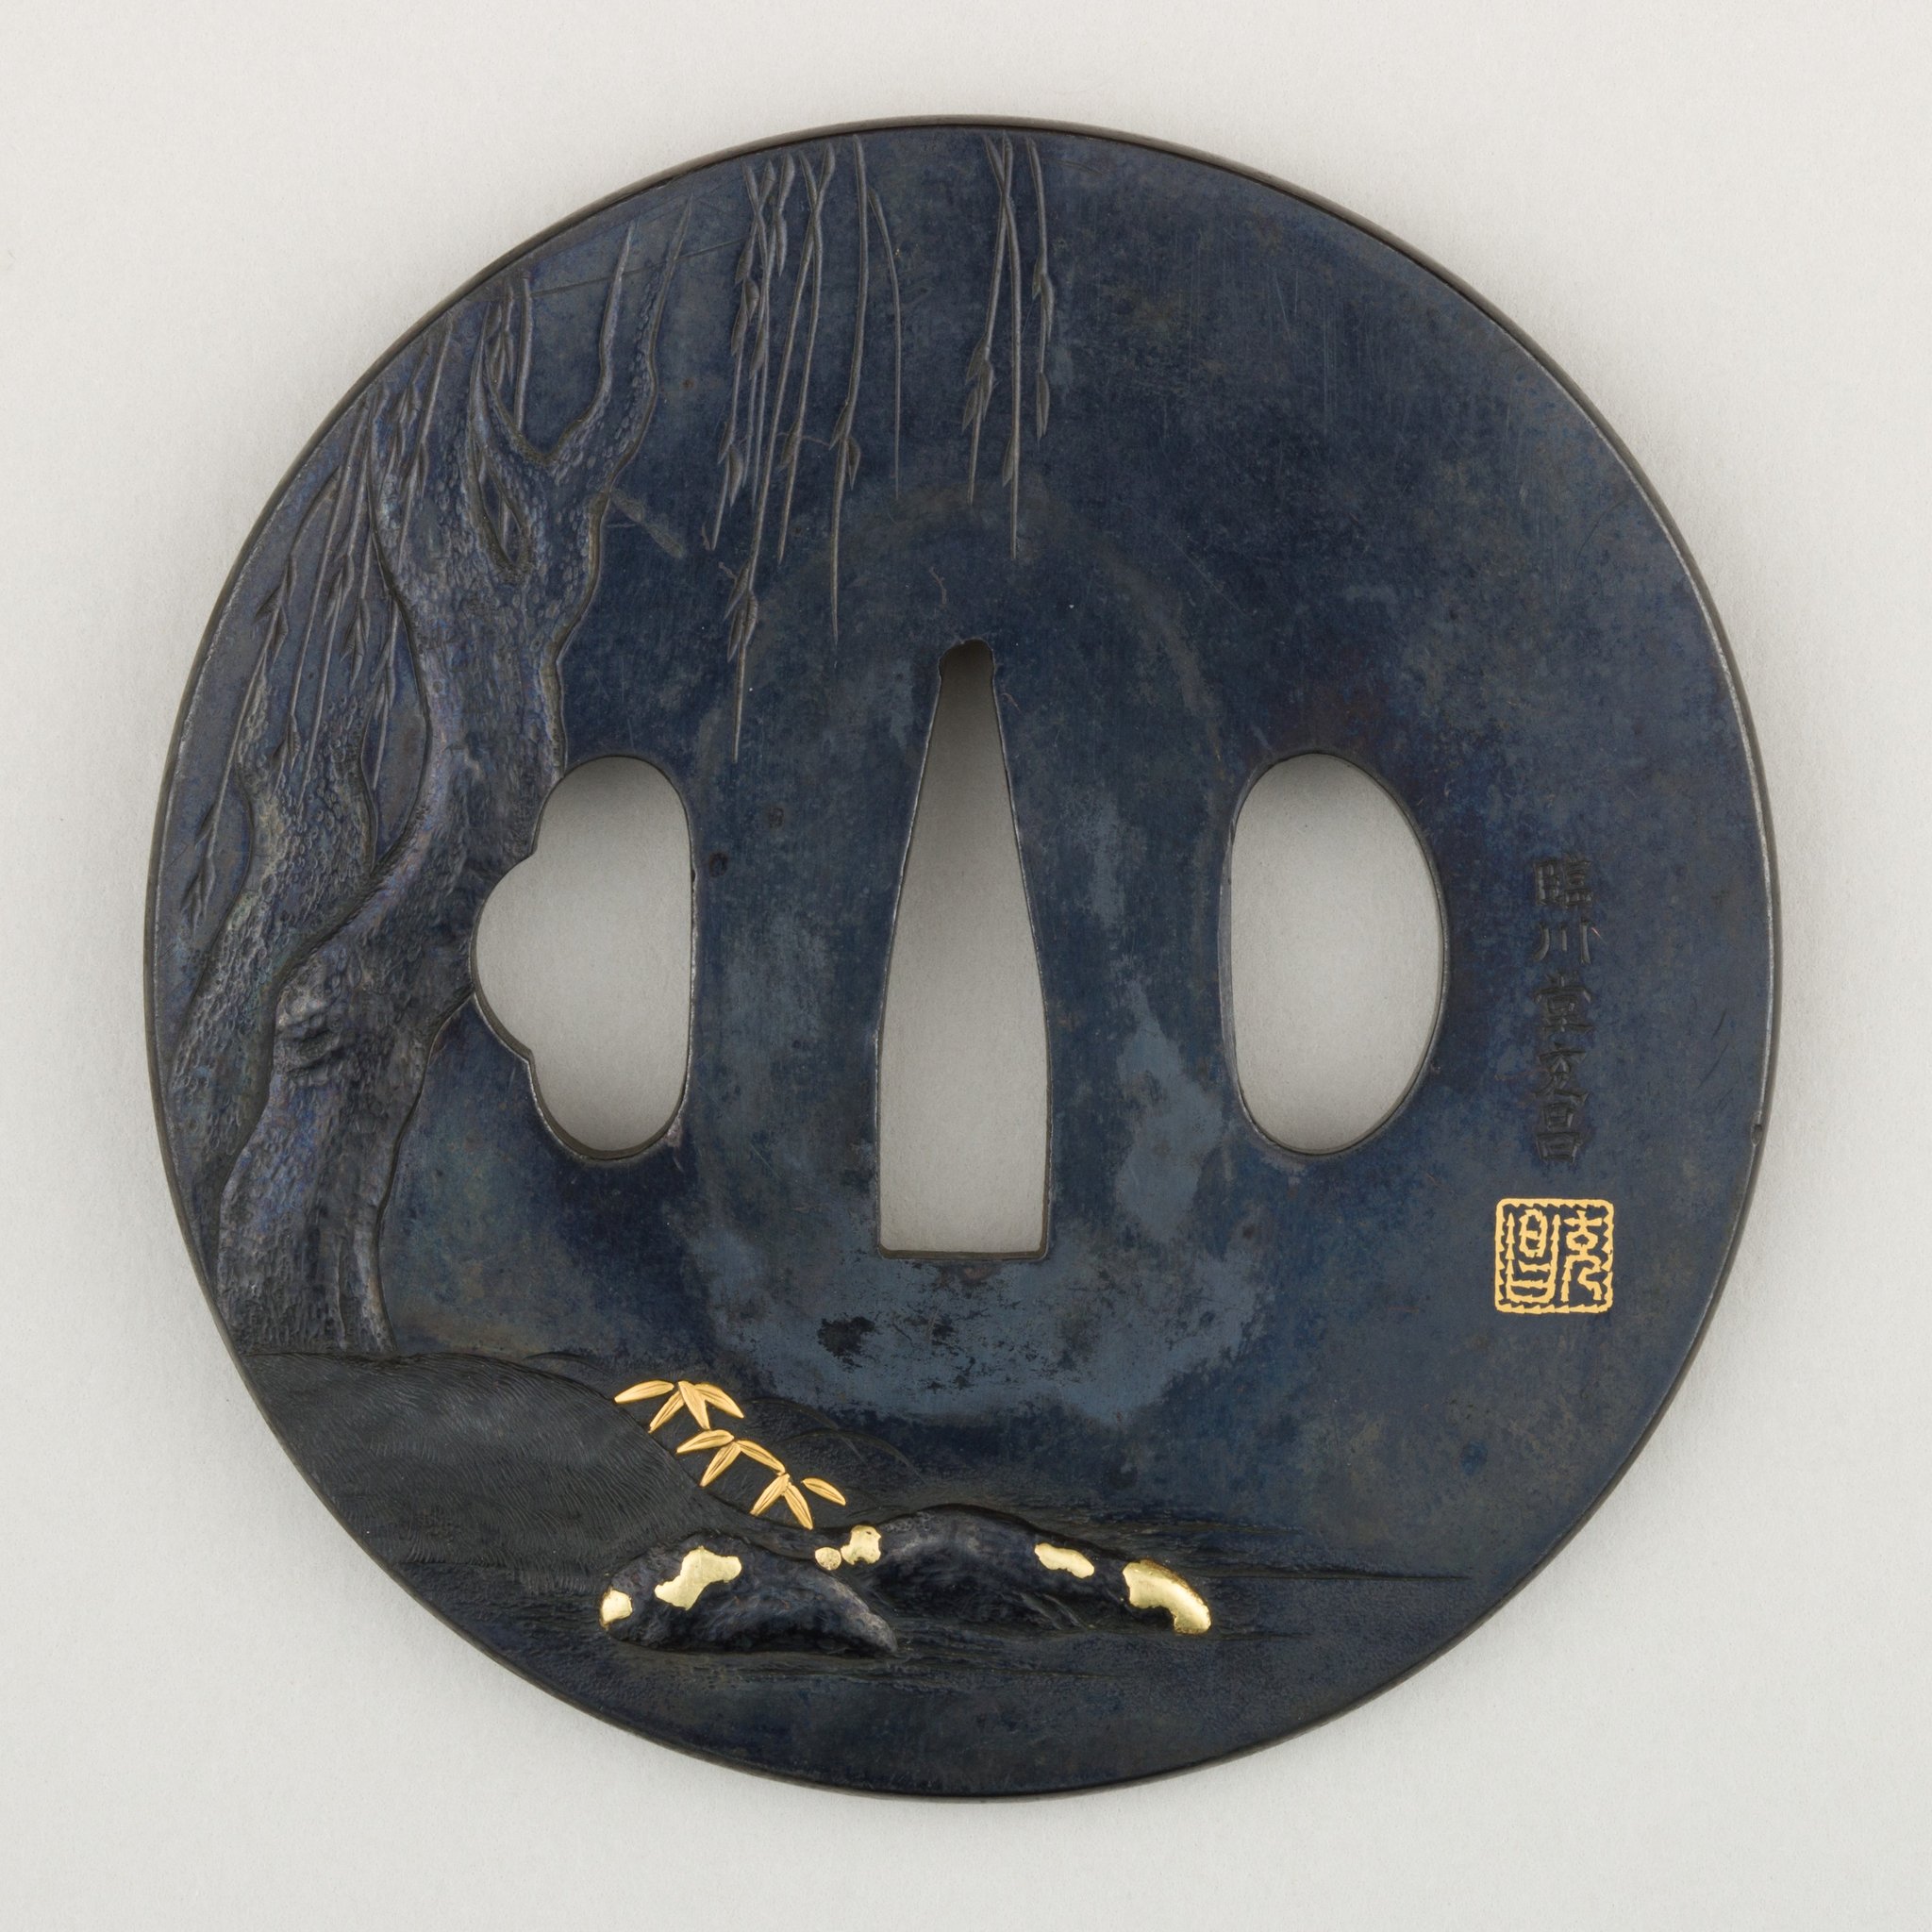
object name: sword guard tsuba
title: Sword Guard (Tsuba)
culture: japanese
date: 1776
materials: bronze, copper, gold alloy, gold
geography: japan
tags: trees